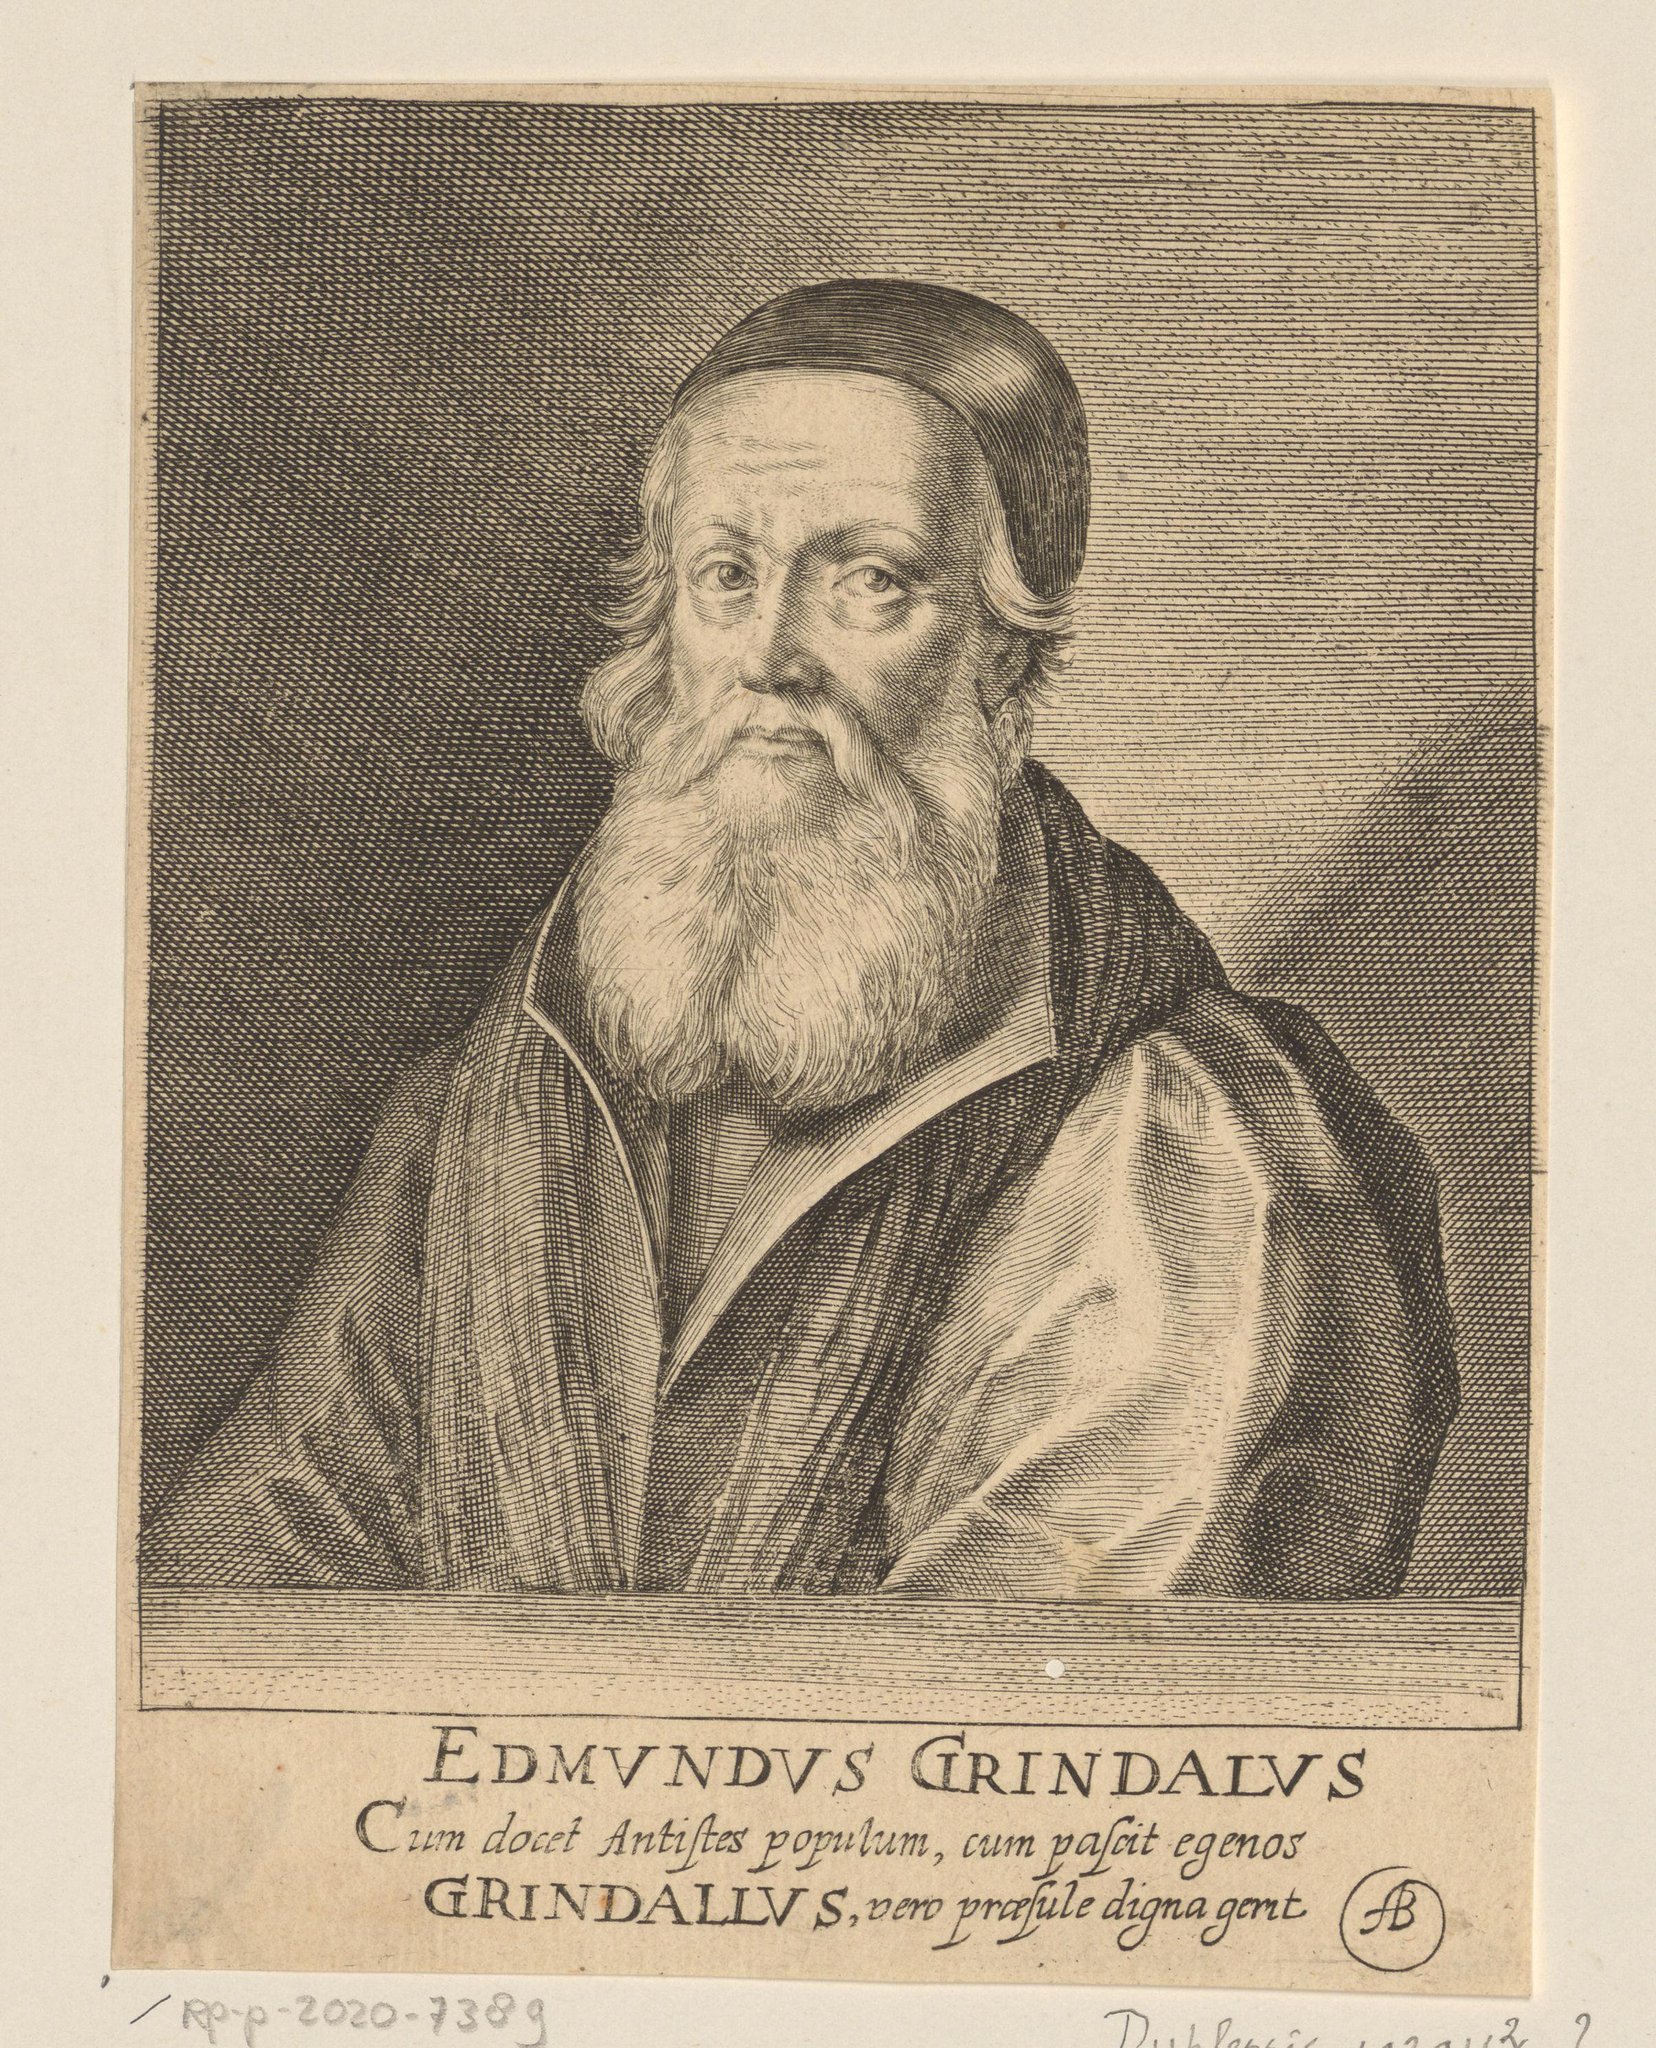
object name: print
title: Portret van Edmund Grindal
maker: Anonymous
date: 1600-1700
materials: paper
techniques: engraving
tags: archbishop, bishop, etc. (roman catholic), historical persons